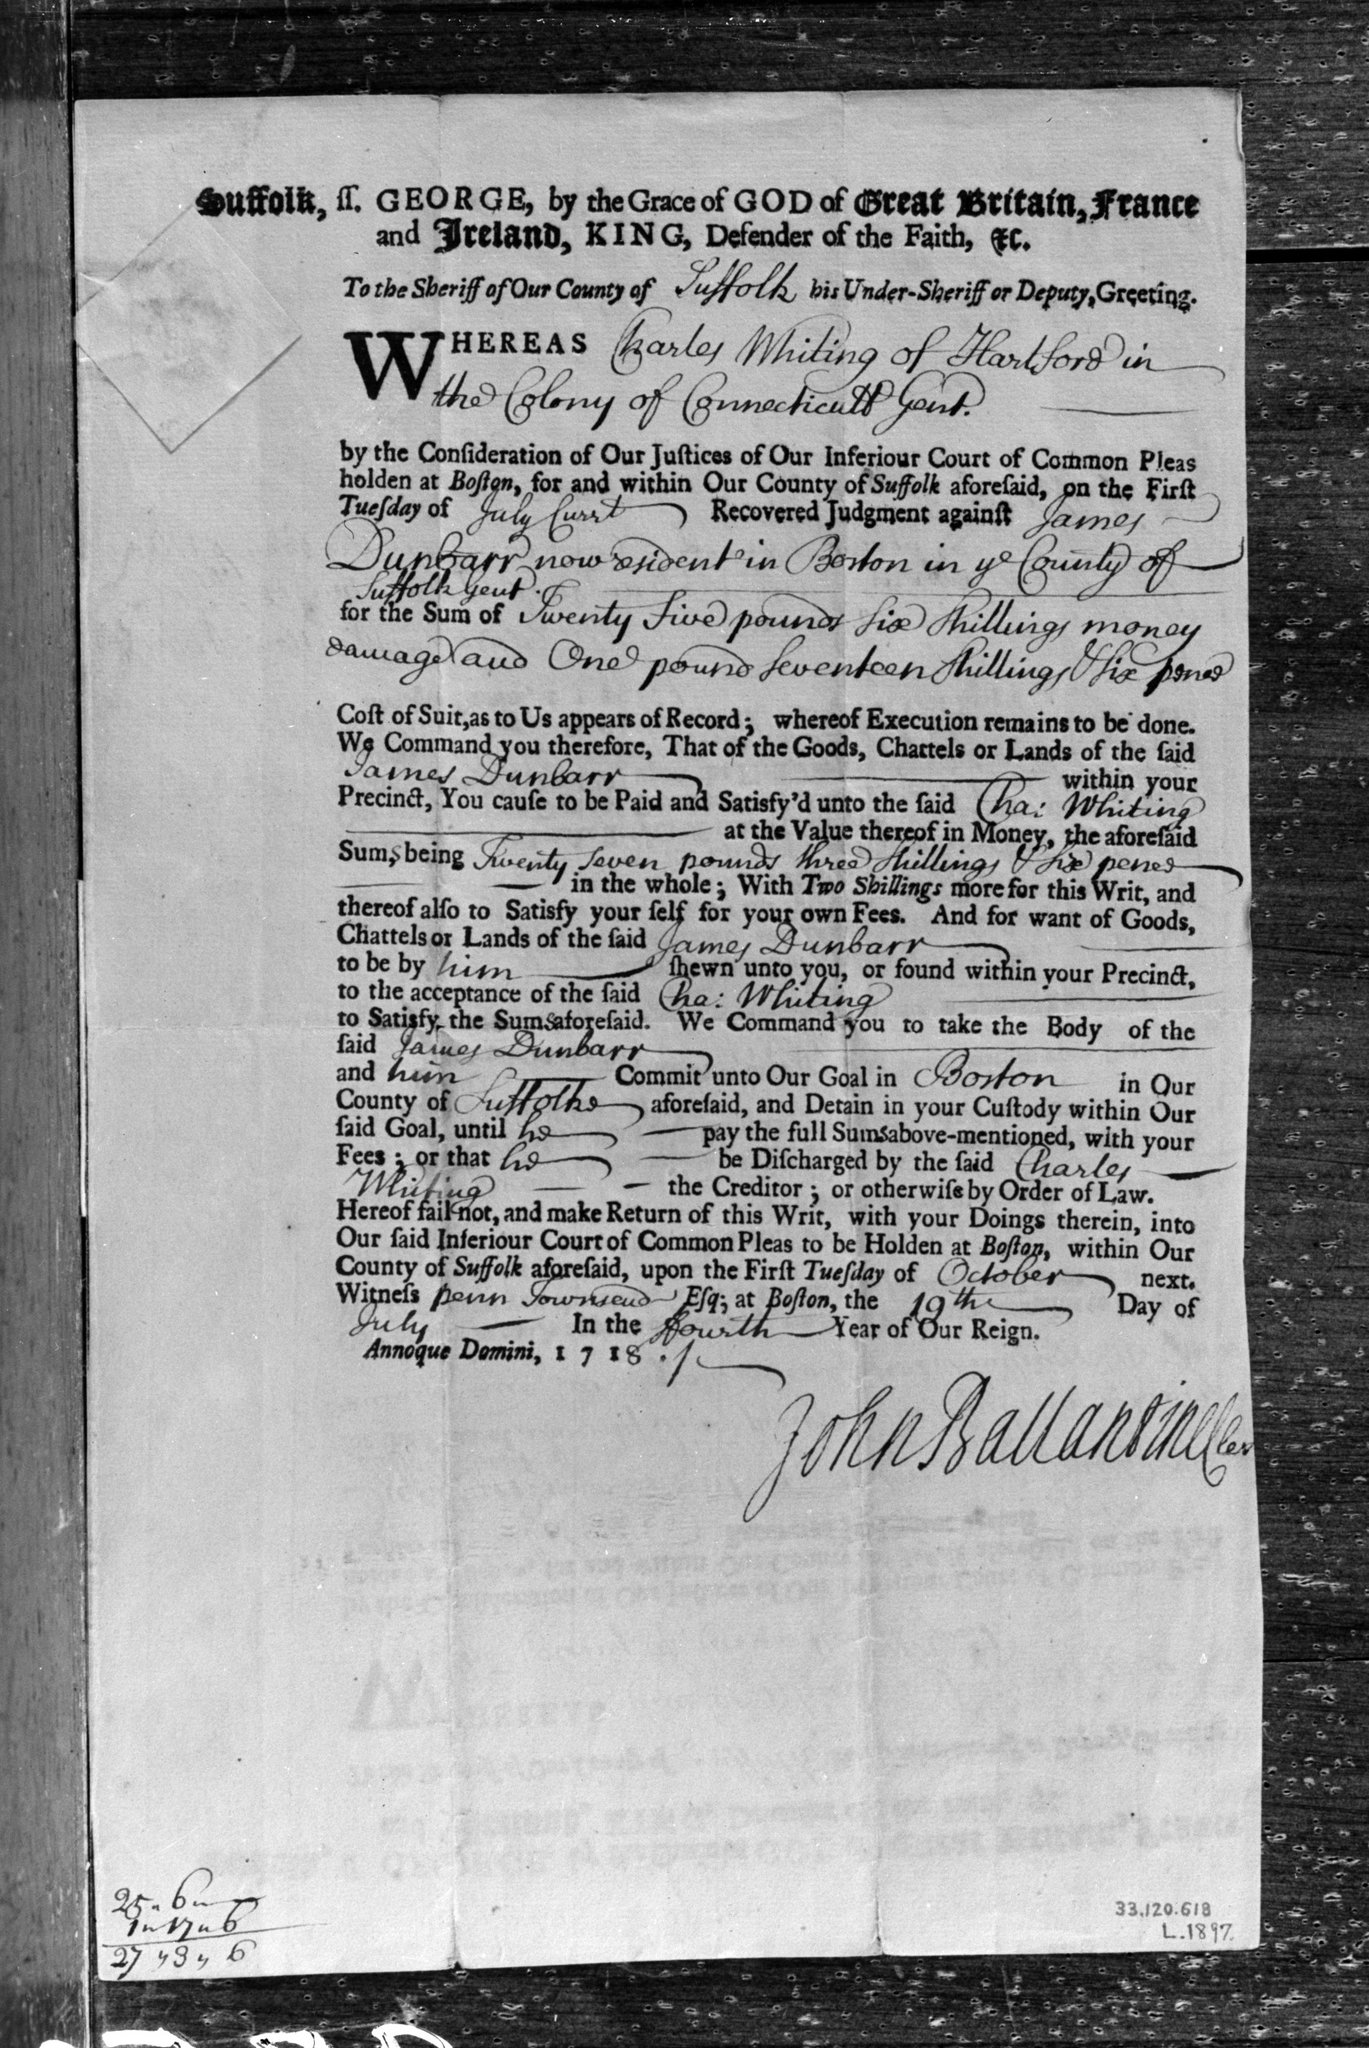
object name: capias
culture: american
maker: edward winslow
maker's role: maker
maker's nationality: american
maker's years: 1669-1753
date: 1718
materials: paper